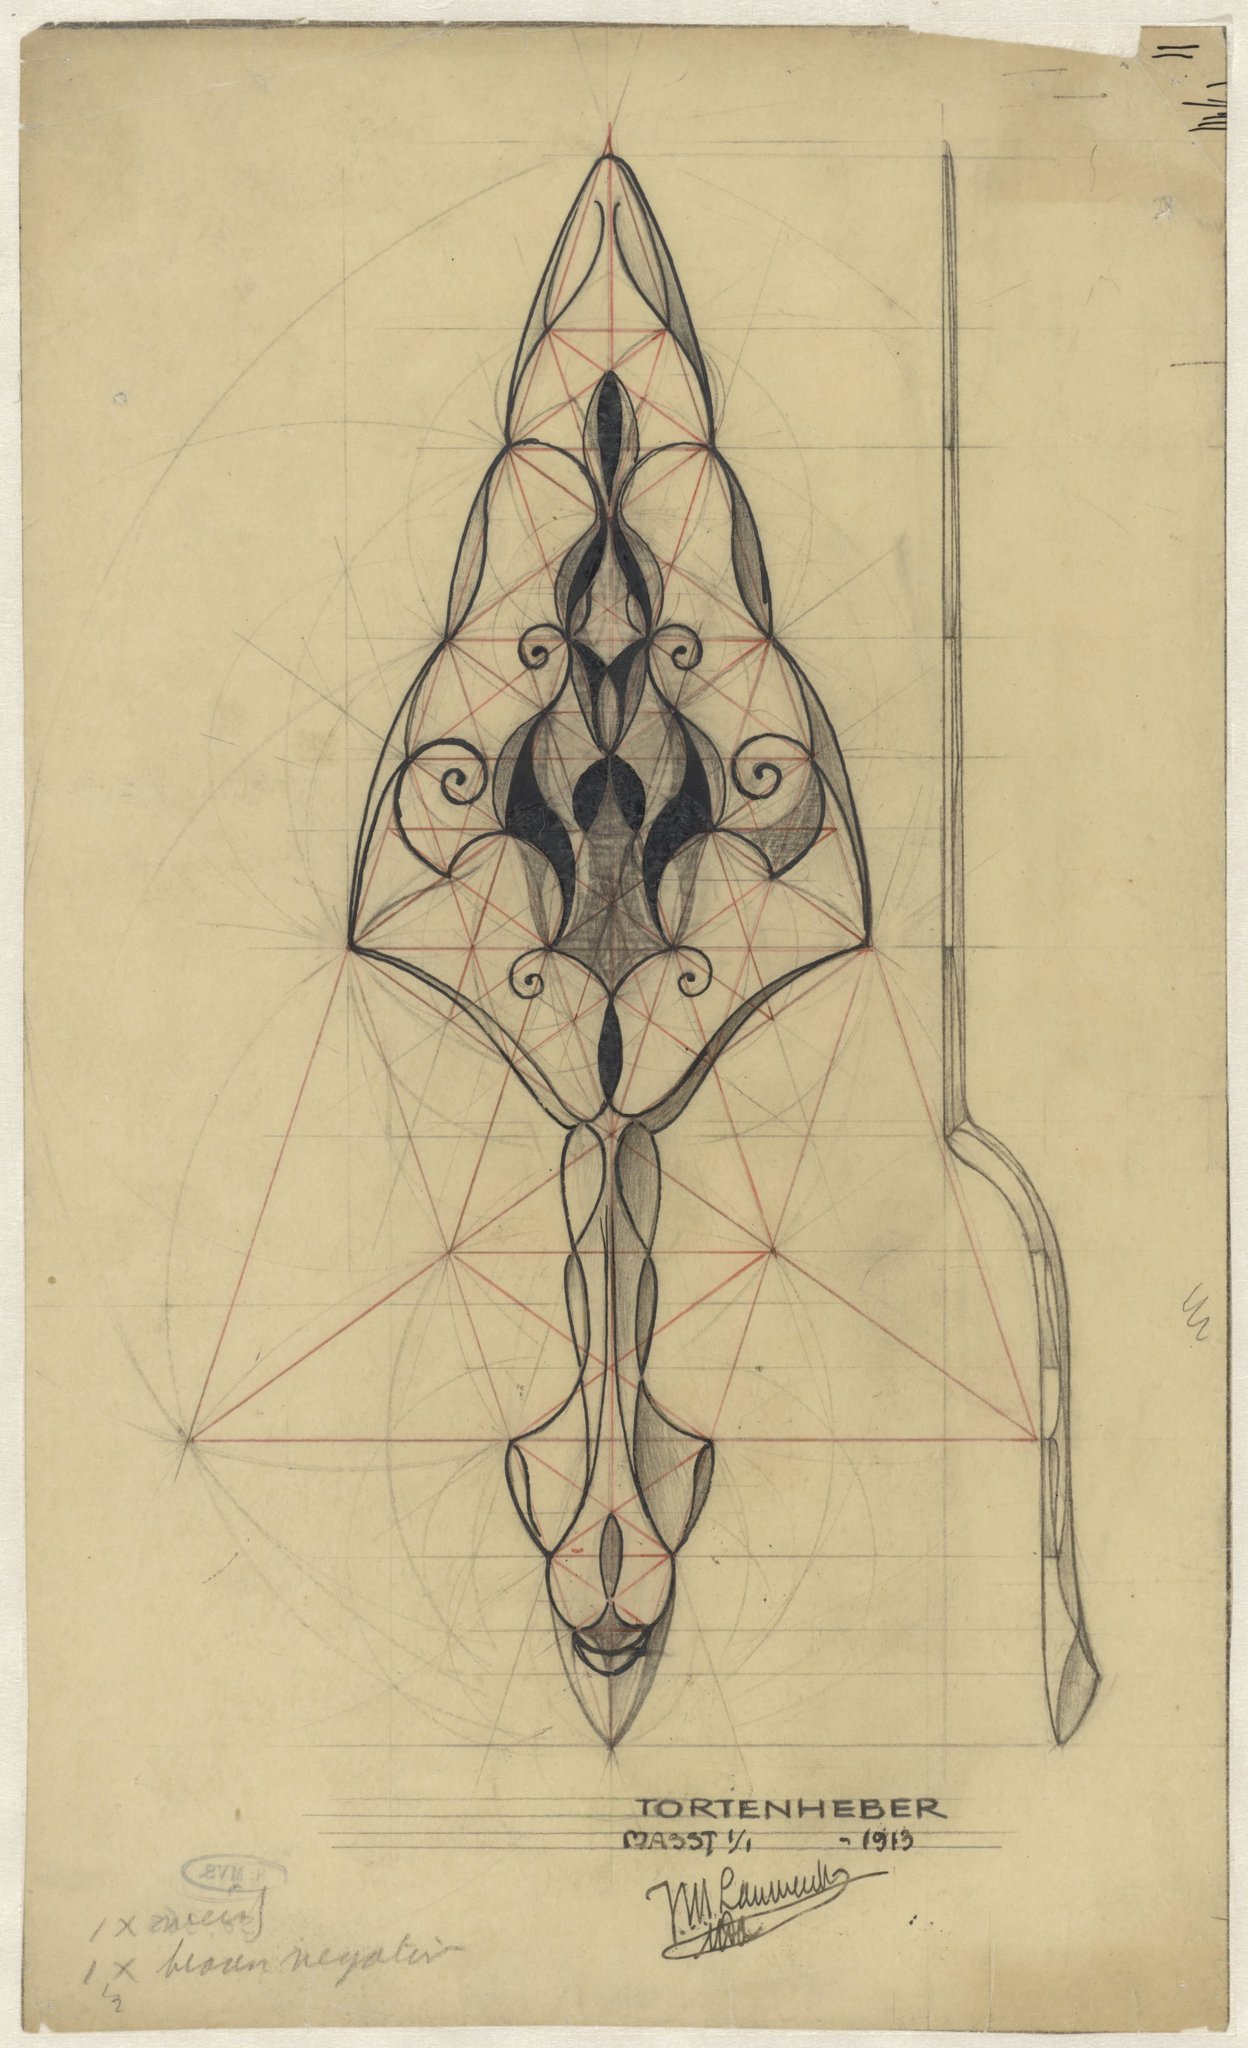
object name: drawing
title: Design for a Cake Server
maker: mathieu lauweriks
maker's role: designer, draughtsman, print maker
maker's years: 1864-1932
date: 1913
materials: ink, pencil, paper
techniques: pen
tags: table-ware, cake, tart, pastry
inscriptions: date: ‘1913’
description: The principles of designing ‘by system’ are evident in this design for a cake server. The basic shape is a triangle within which smaller circles and triangles define the proportions and dimensions of the design. The cake server is drawn life-size in front and side views, and a natural form unfolds from the tangle of geometric shapes.